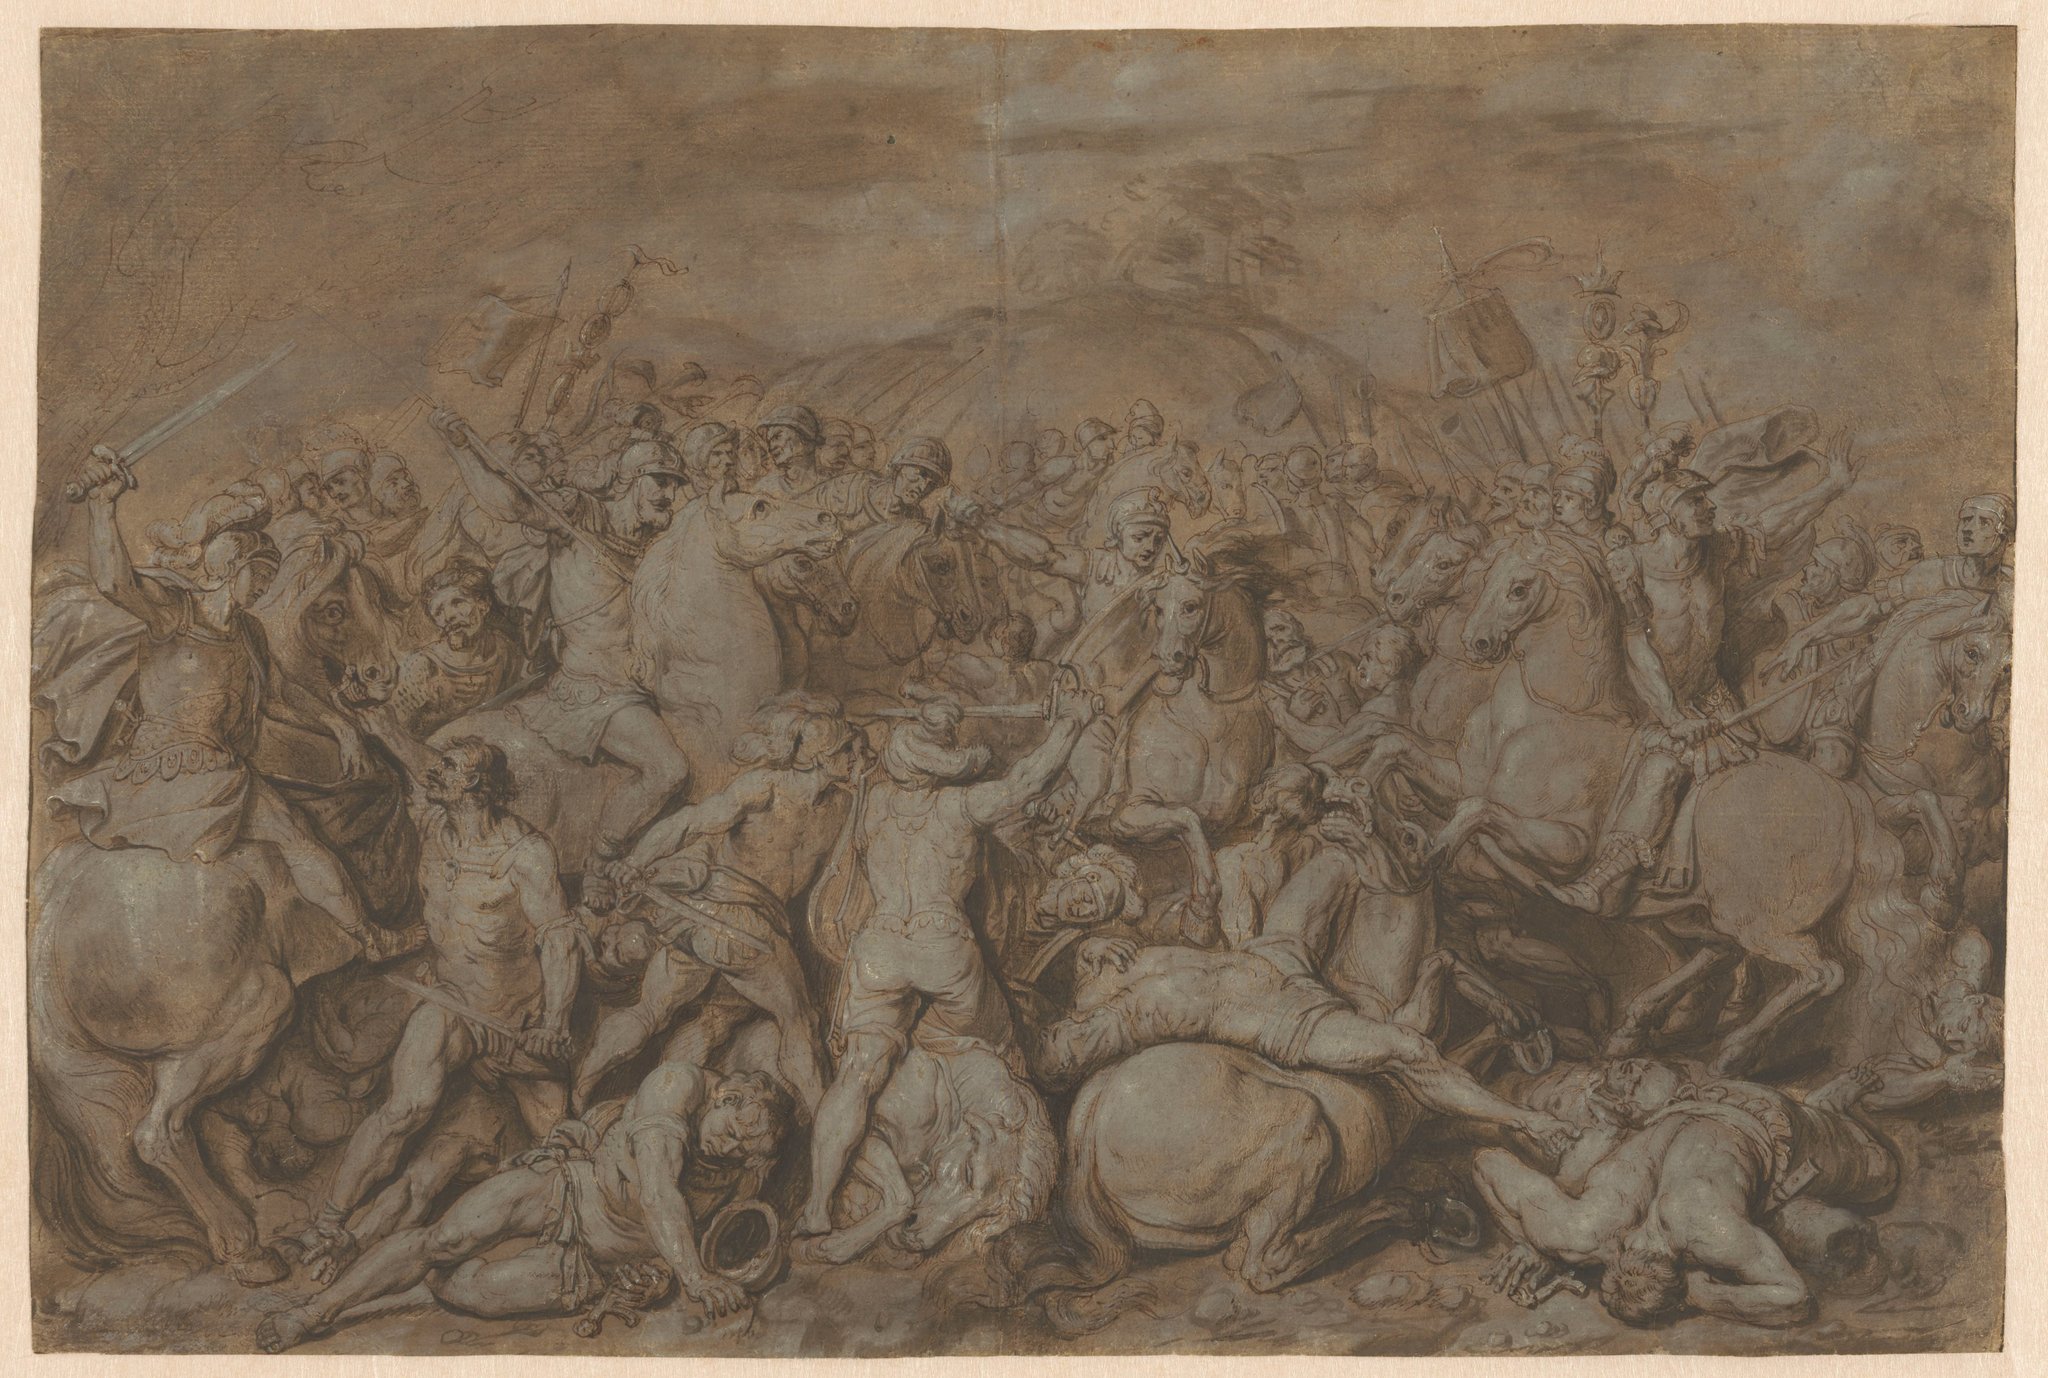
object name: drawing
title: Ruiterslag in de antieke oudheid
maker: Anonymous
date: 1590-1610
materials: paint, gouache, paper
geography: italy